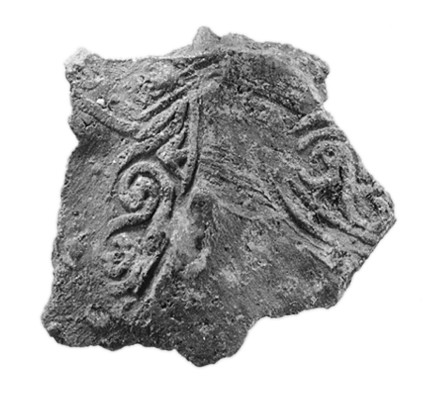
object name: sealing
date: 1981-1640 BCE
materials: mud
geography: egypt